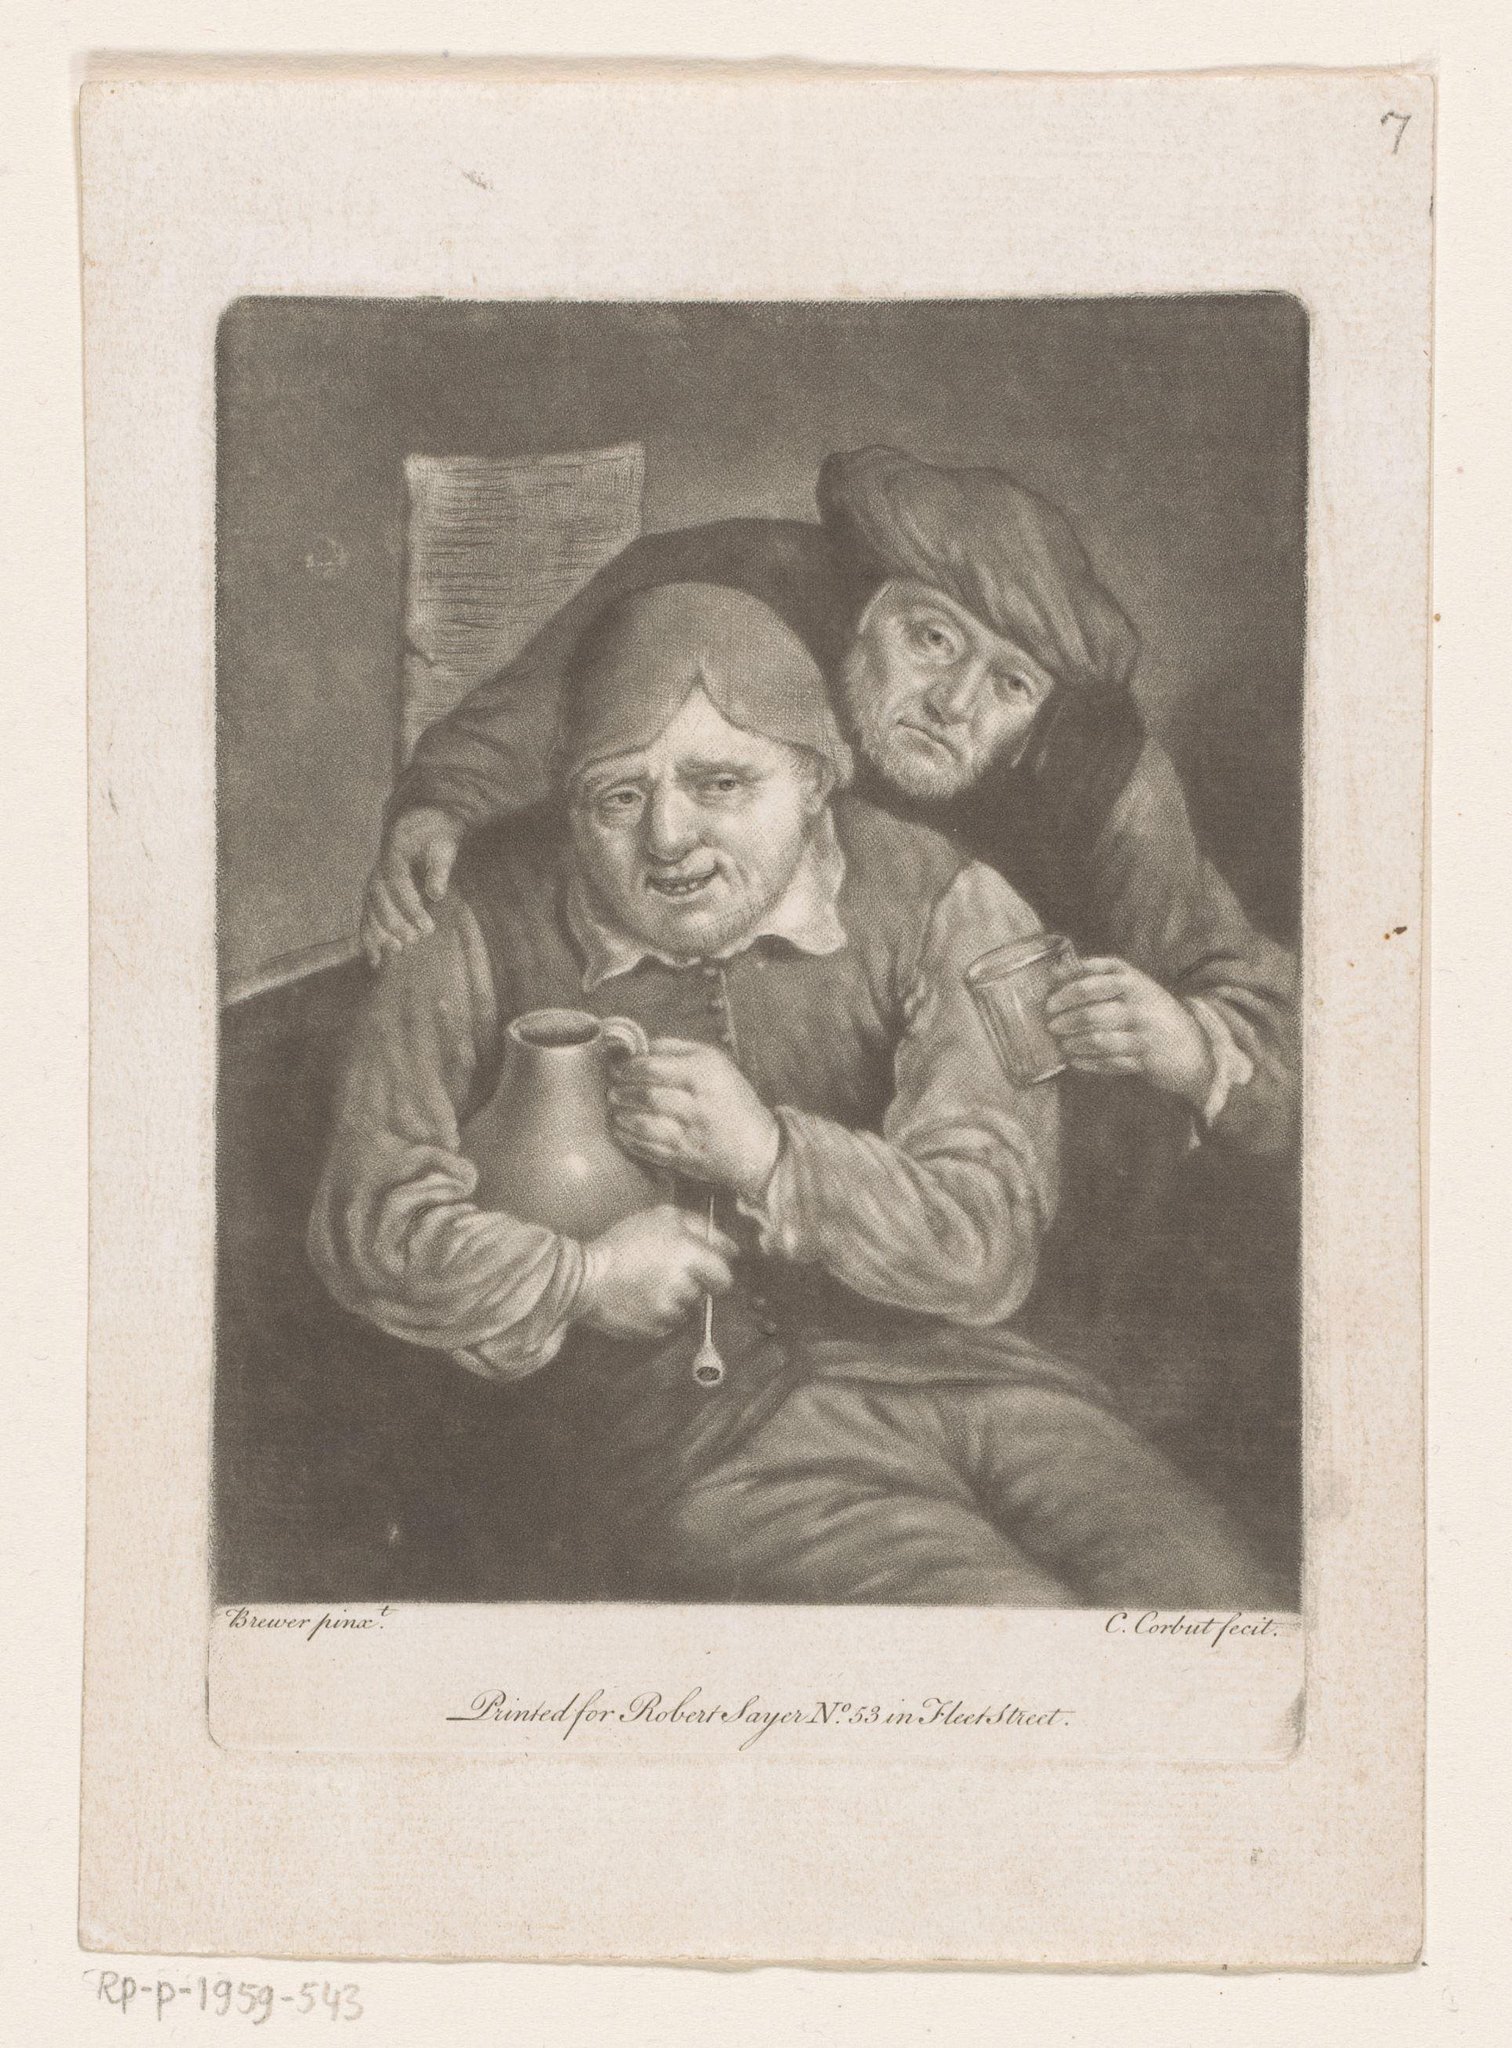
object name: print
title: Twee drinkende boeren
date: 1745-1794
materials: paper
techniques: mezzotint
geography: london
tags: farmers, drinking, hotel, hostelry, inn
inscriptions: collector's mark: Lugt 2228